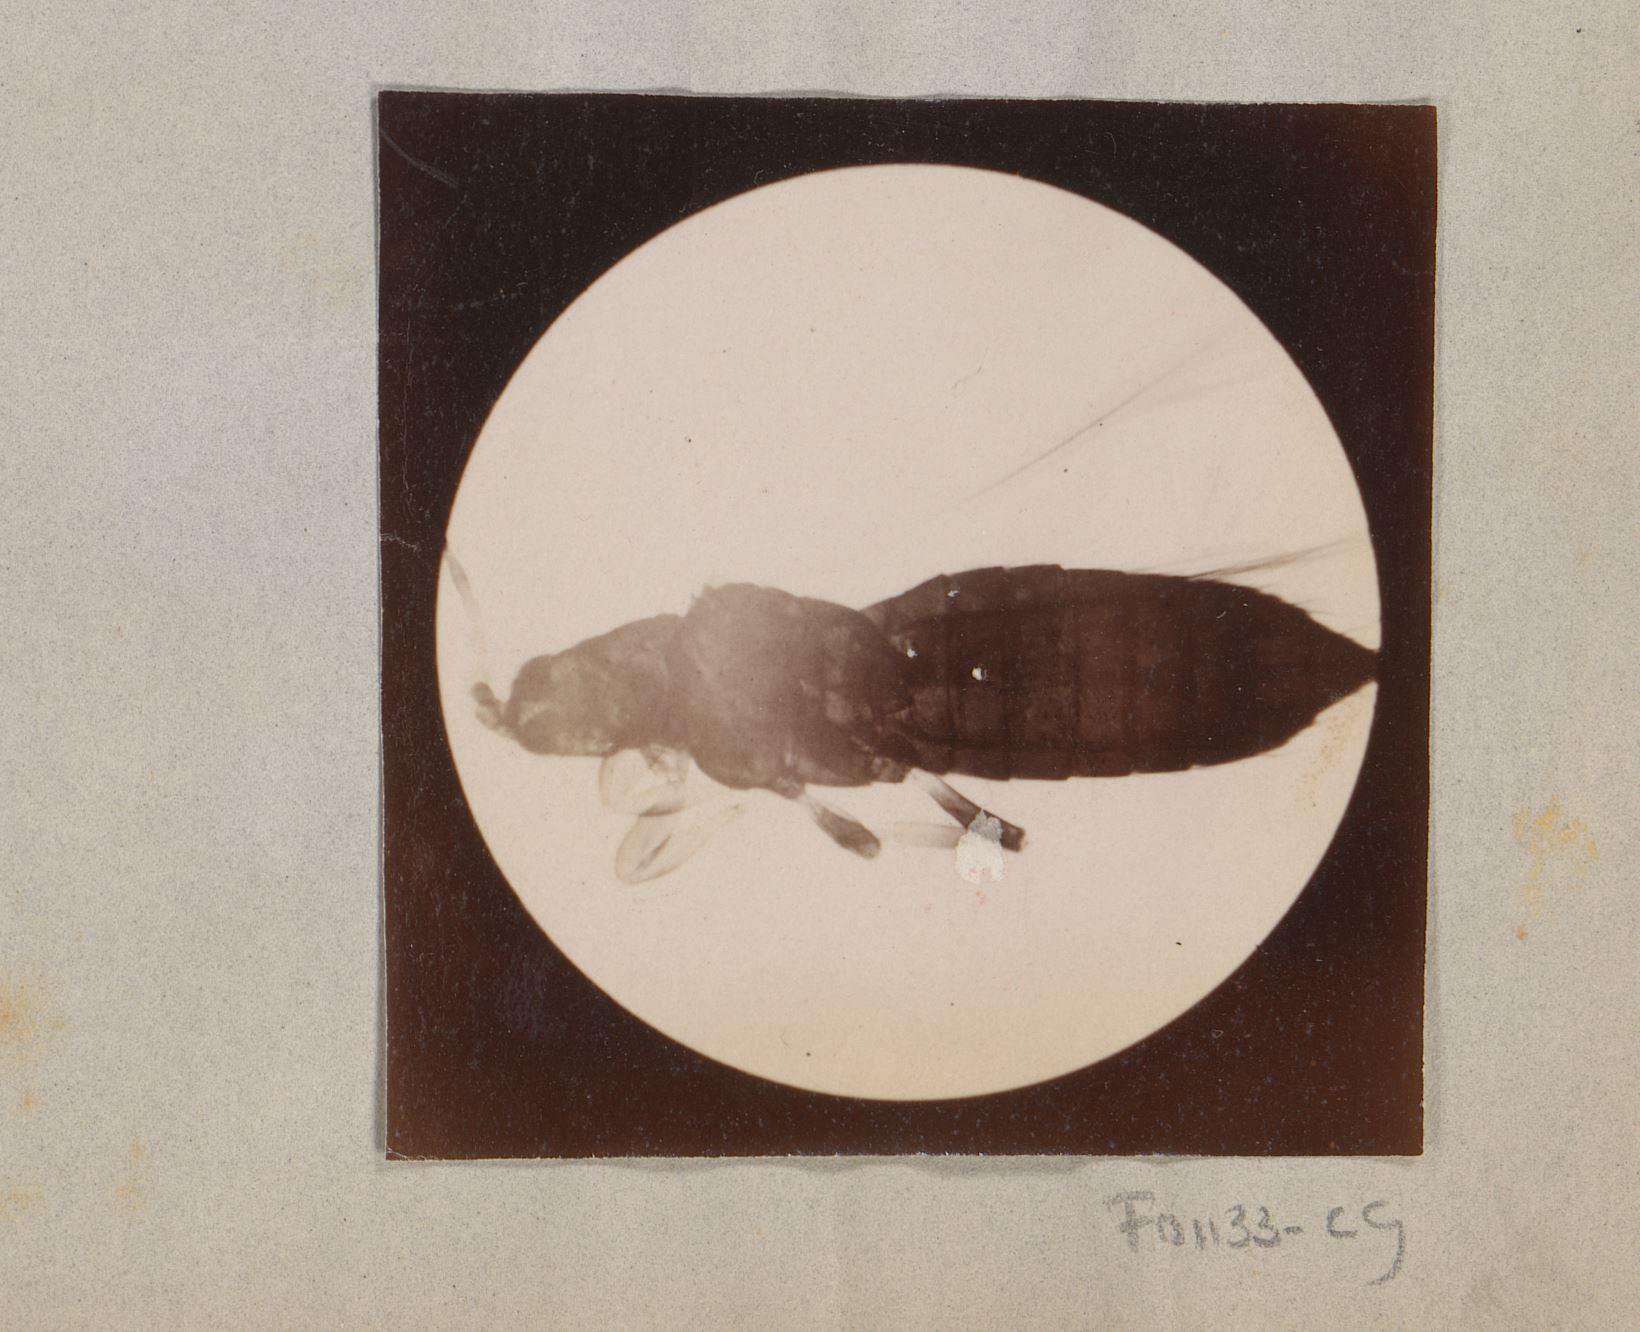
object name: photograph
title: Microscopische opname van een insect, zestig keer vergroot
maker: marinus pieter filbri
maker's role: instrument maker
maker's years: 1852-1917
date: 1887-1888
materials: paper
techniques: albumen print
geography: netherlands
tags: insects, netherlands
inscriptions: inscription: ‘Studie voor pose bij wetenschappelijk/ onderwerp’